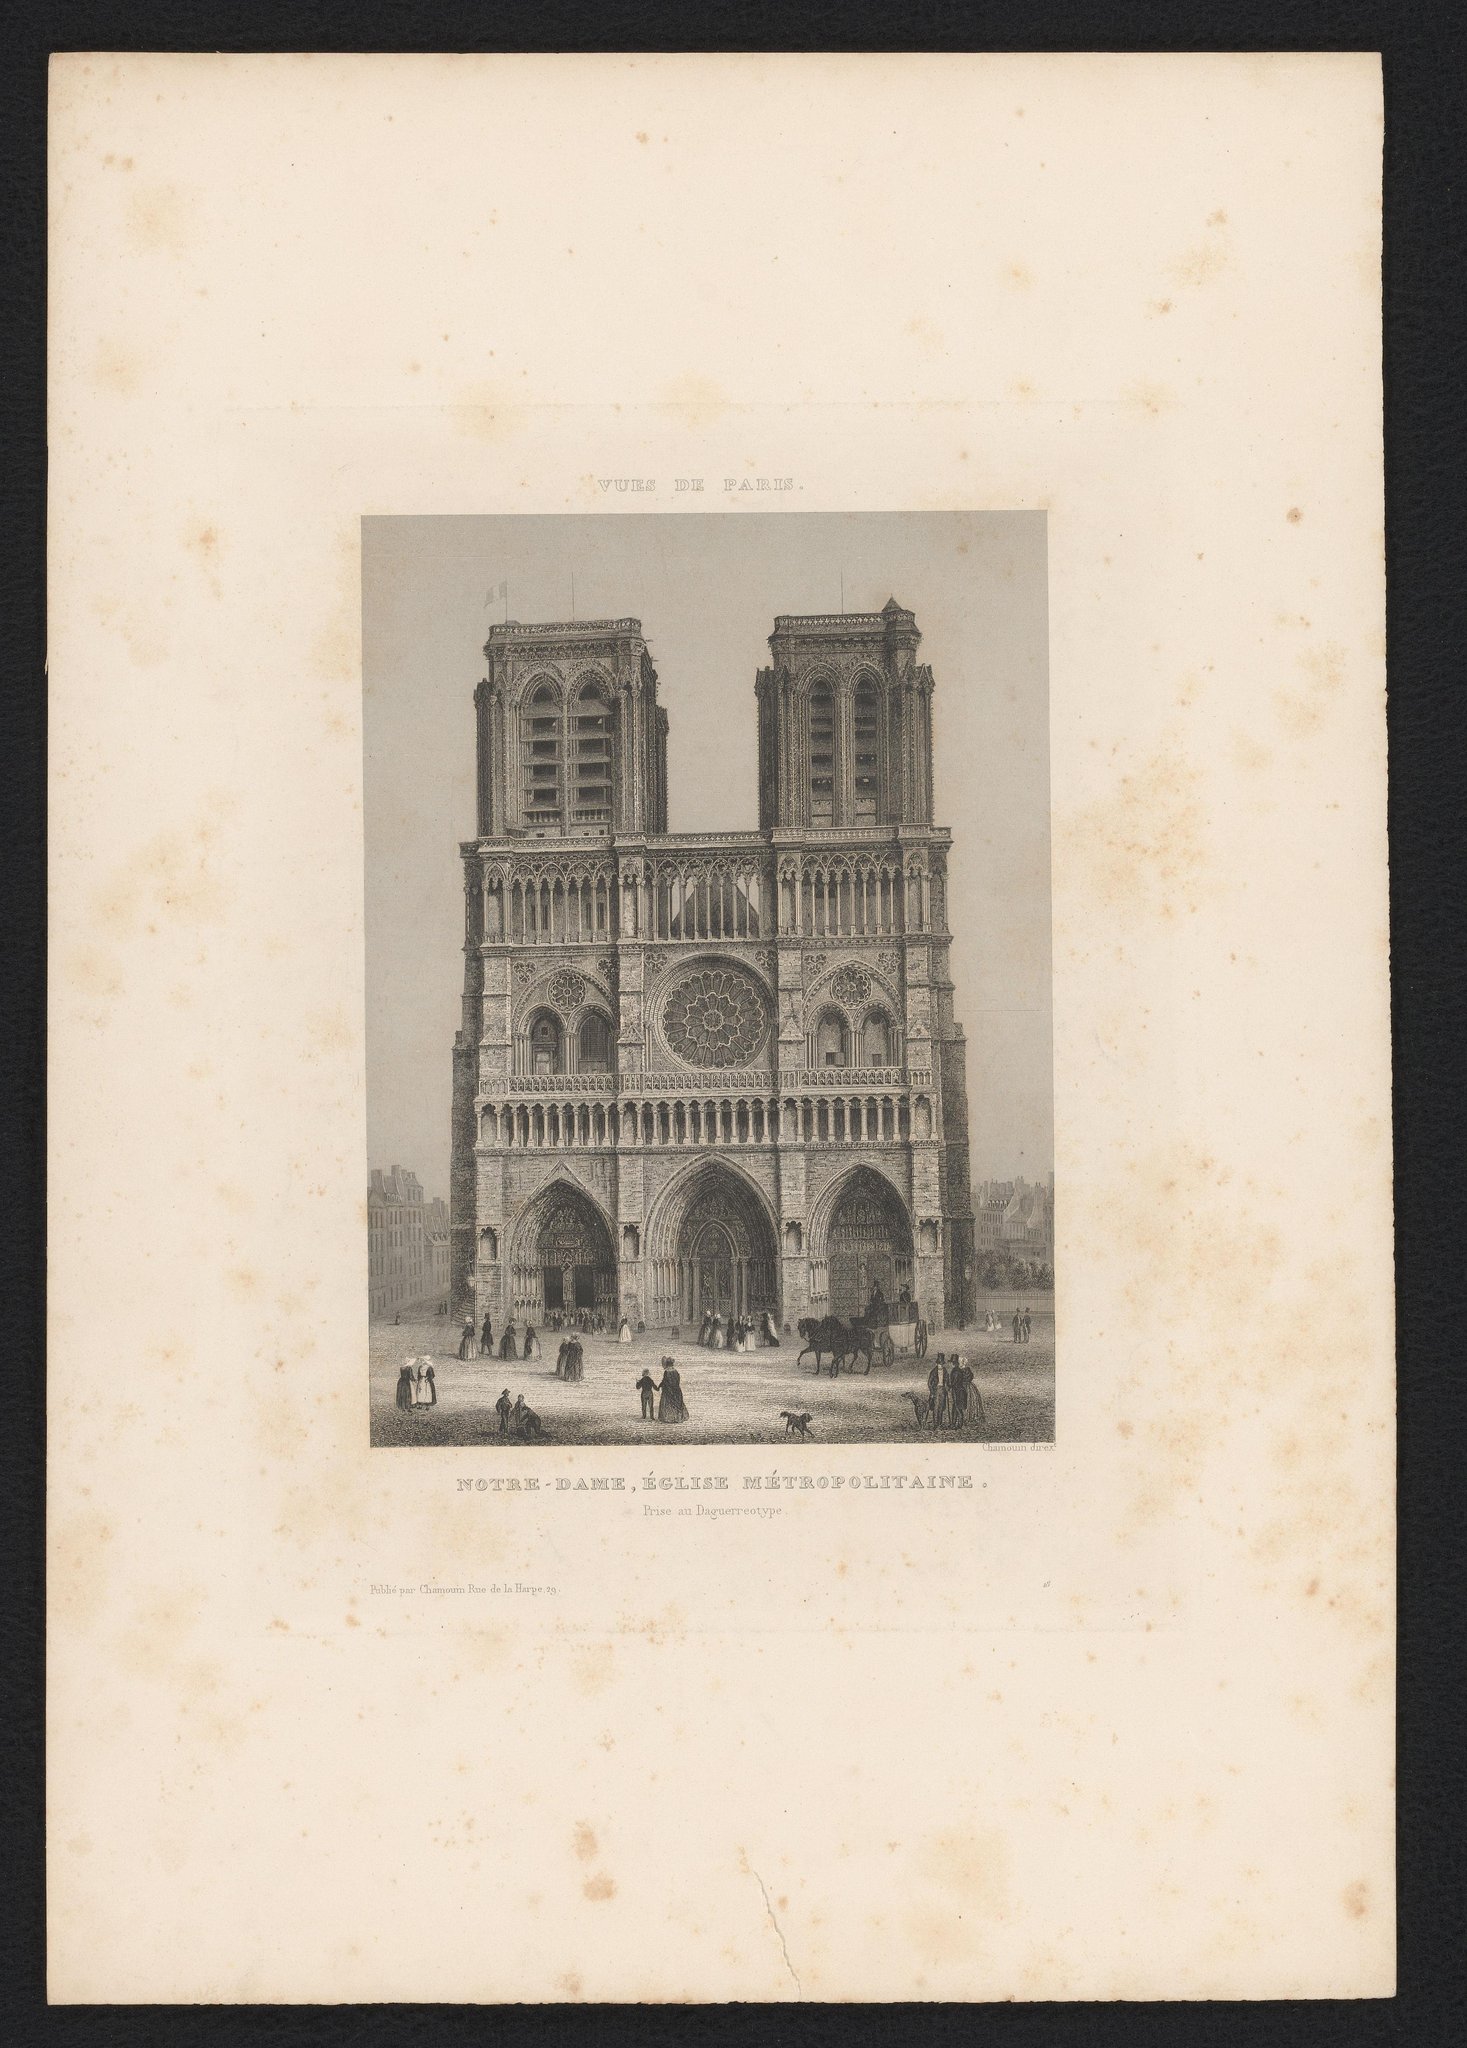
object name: print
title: Gezicht op de Notre-Dame van Parijs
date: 1845-1850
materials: paper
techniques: engraving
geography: paris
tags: church (exterior)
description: Deze prent maakt deel uit van een omslag met 22 prenten op 22 bladen.